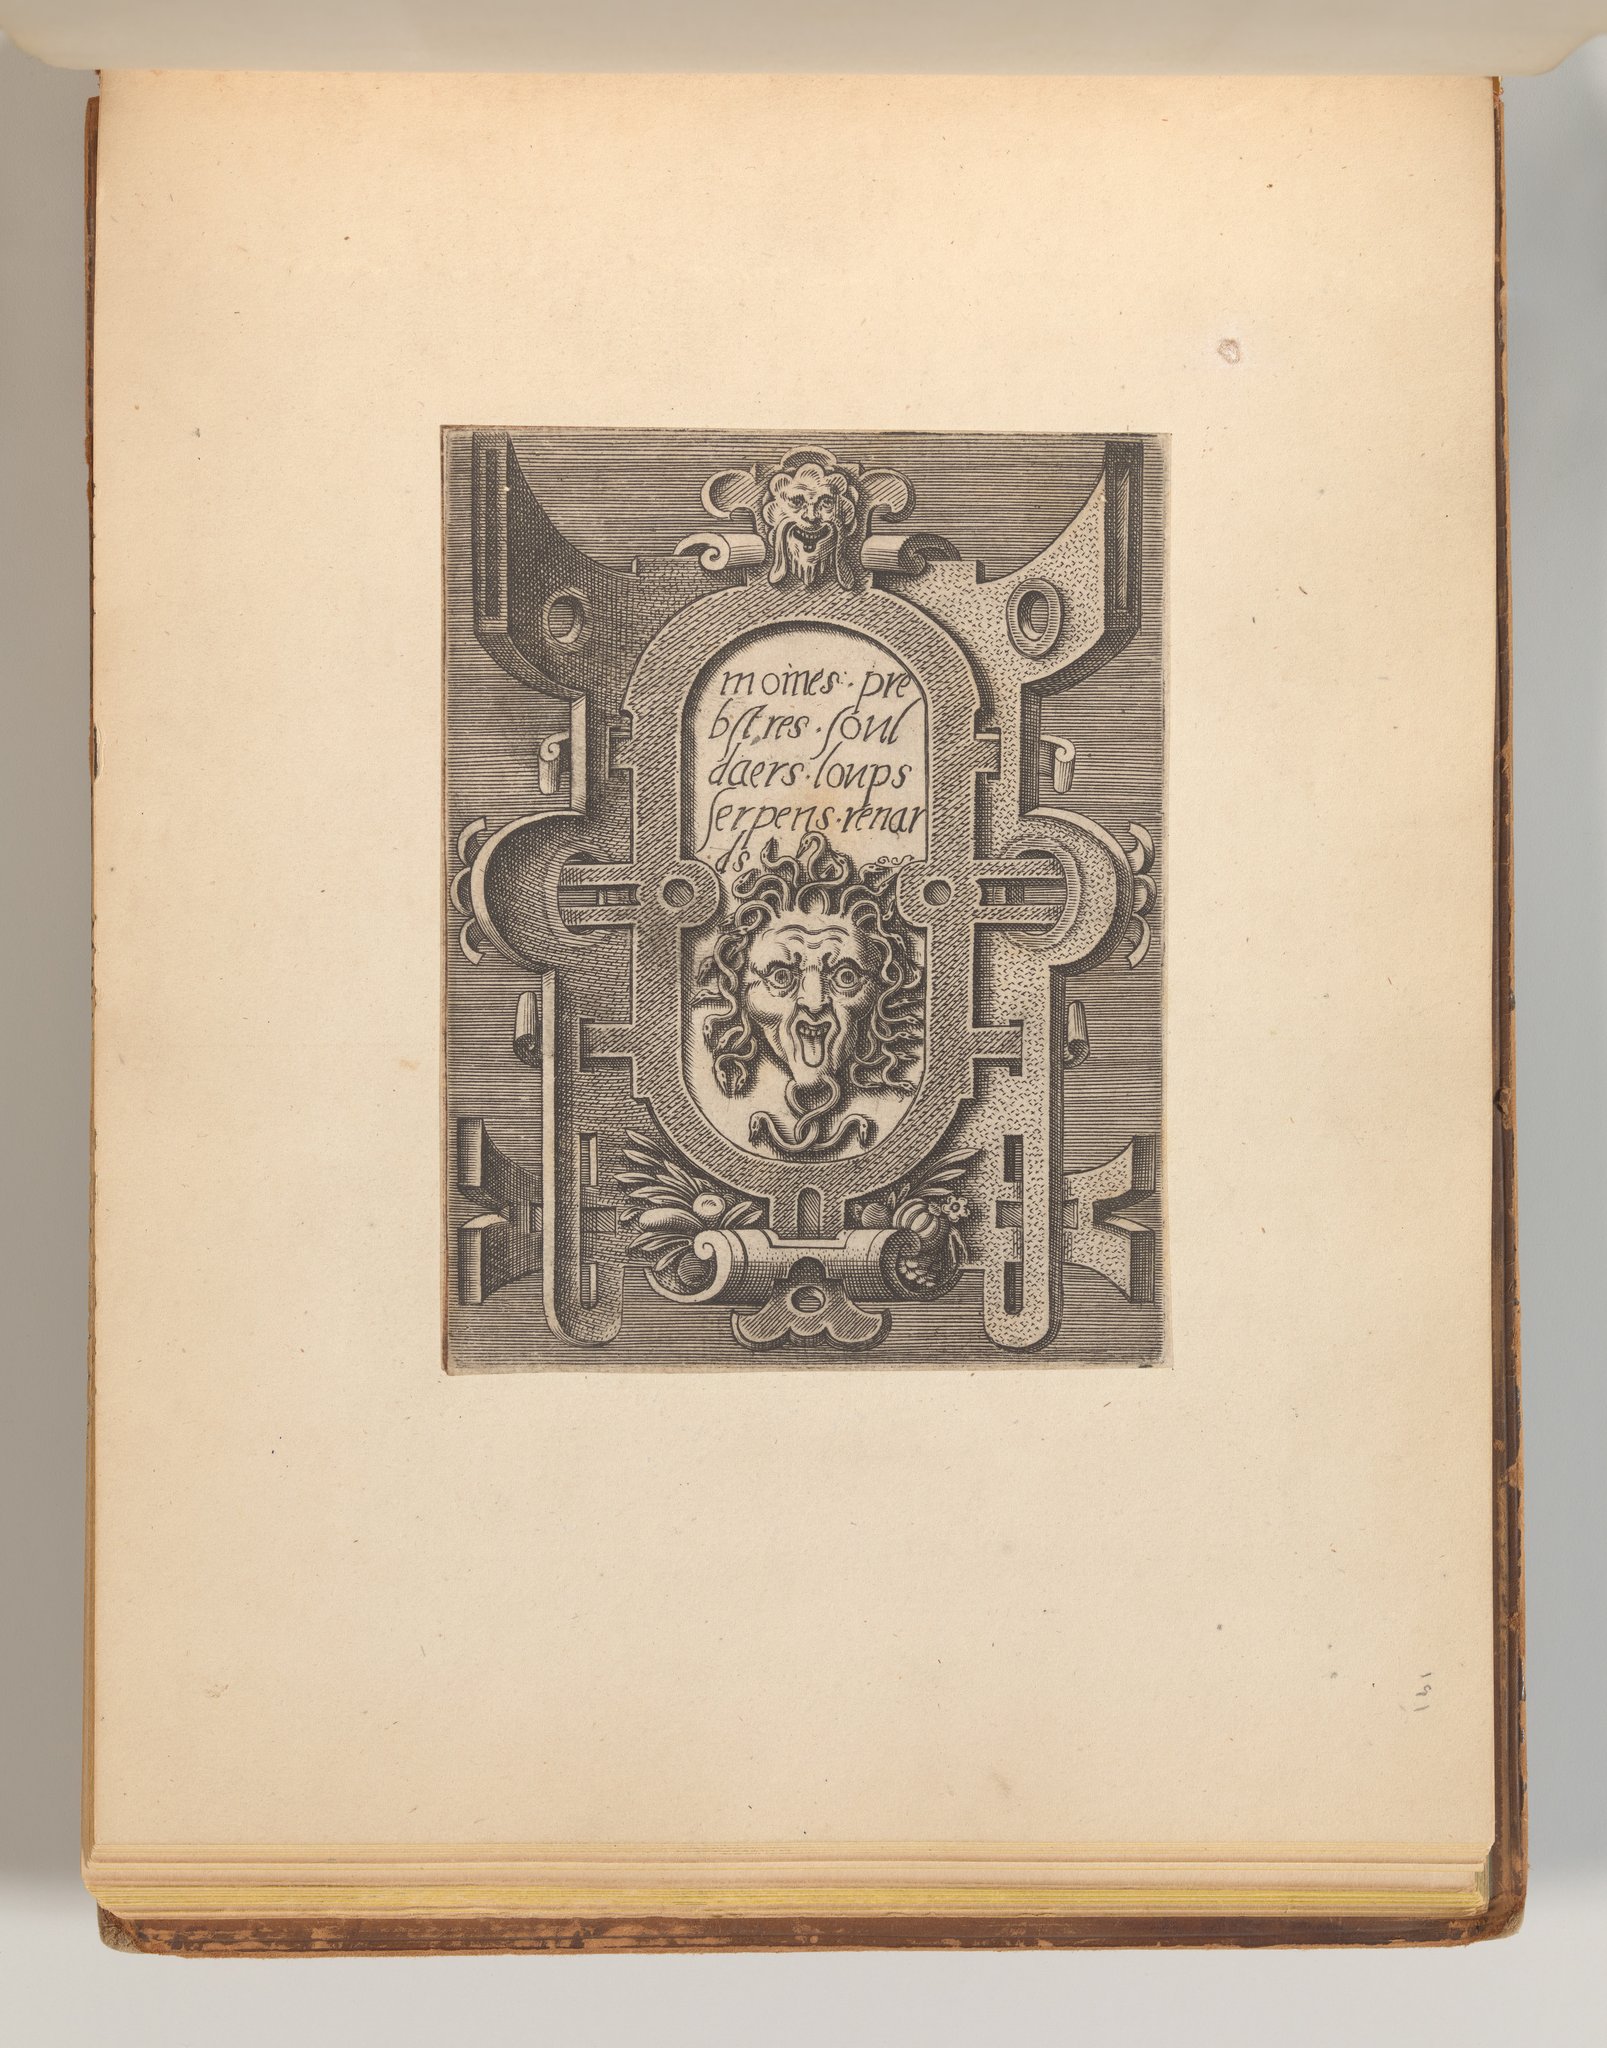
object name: album print ornament architecture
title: Series fof Cartouches, in: Targhe ed altri ornati di varie e capricciose invenzioni (Cartouches and other ornaments of various and capricious invention, page 34)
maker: cornelis bos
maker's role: artist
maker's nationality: netherlandish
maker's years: 1510-1556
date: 1545-1560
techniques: engraving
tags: cartouches,faces